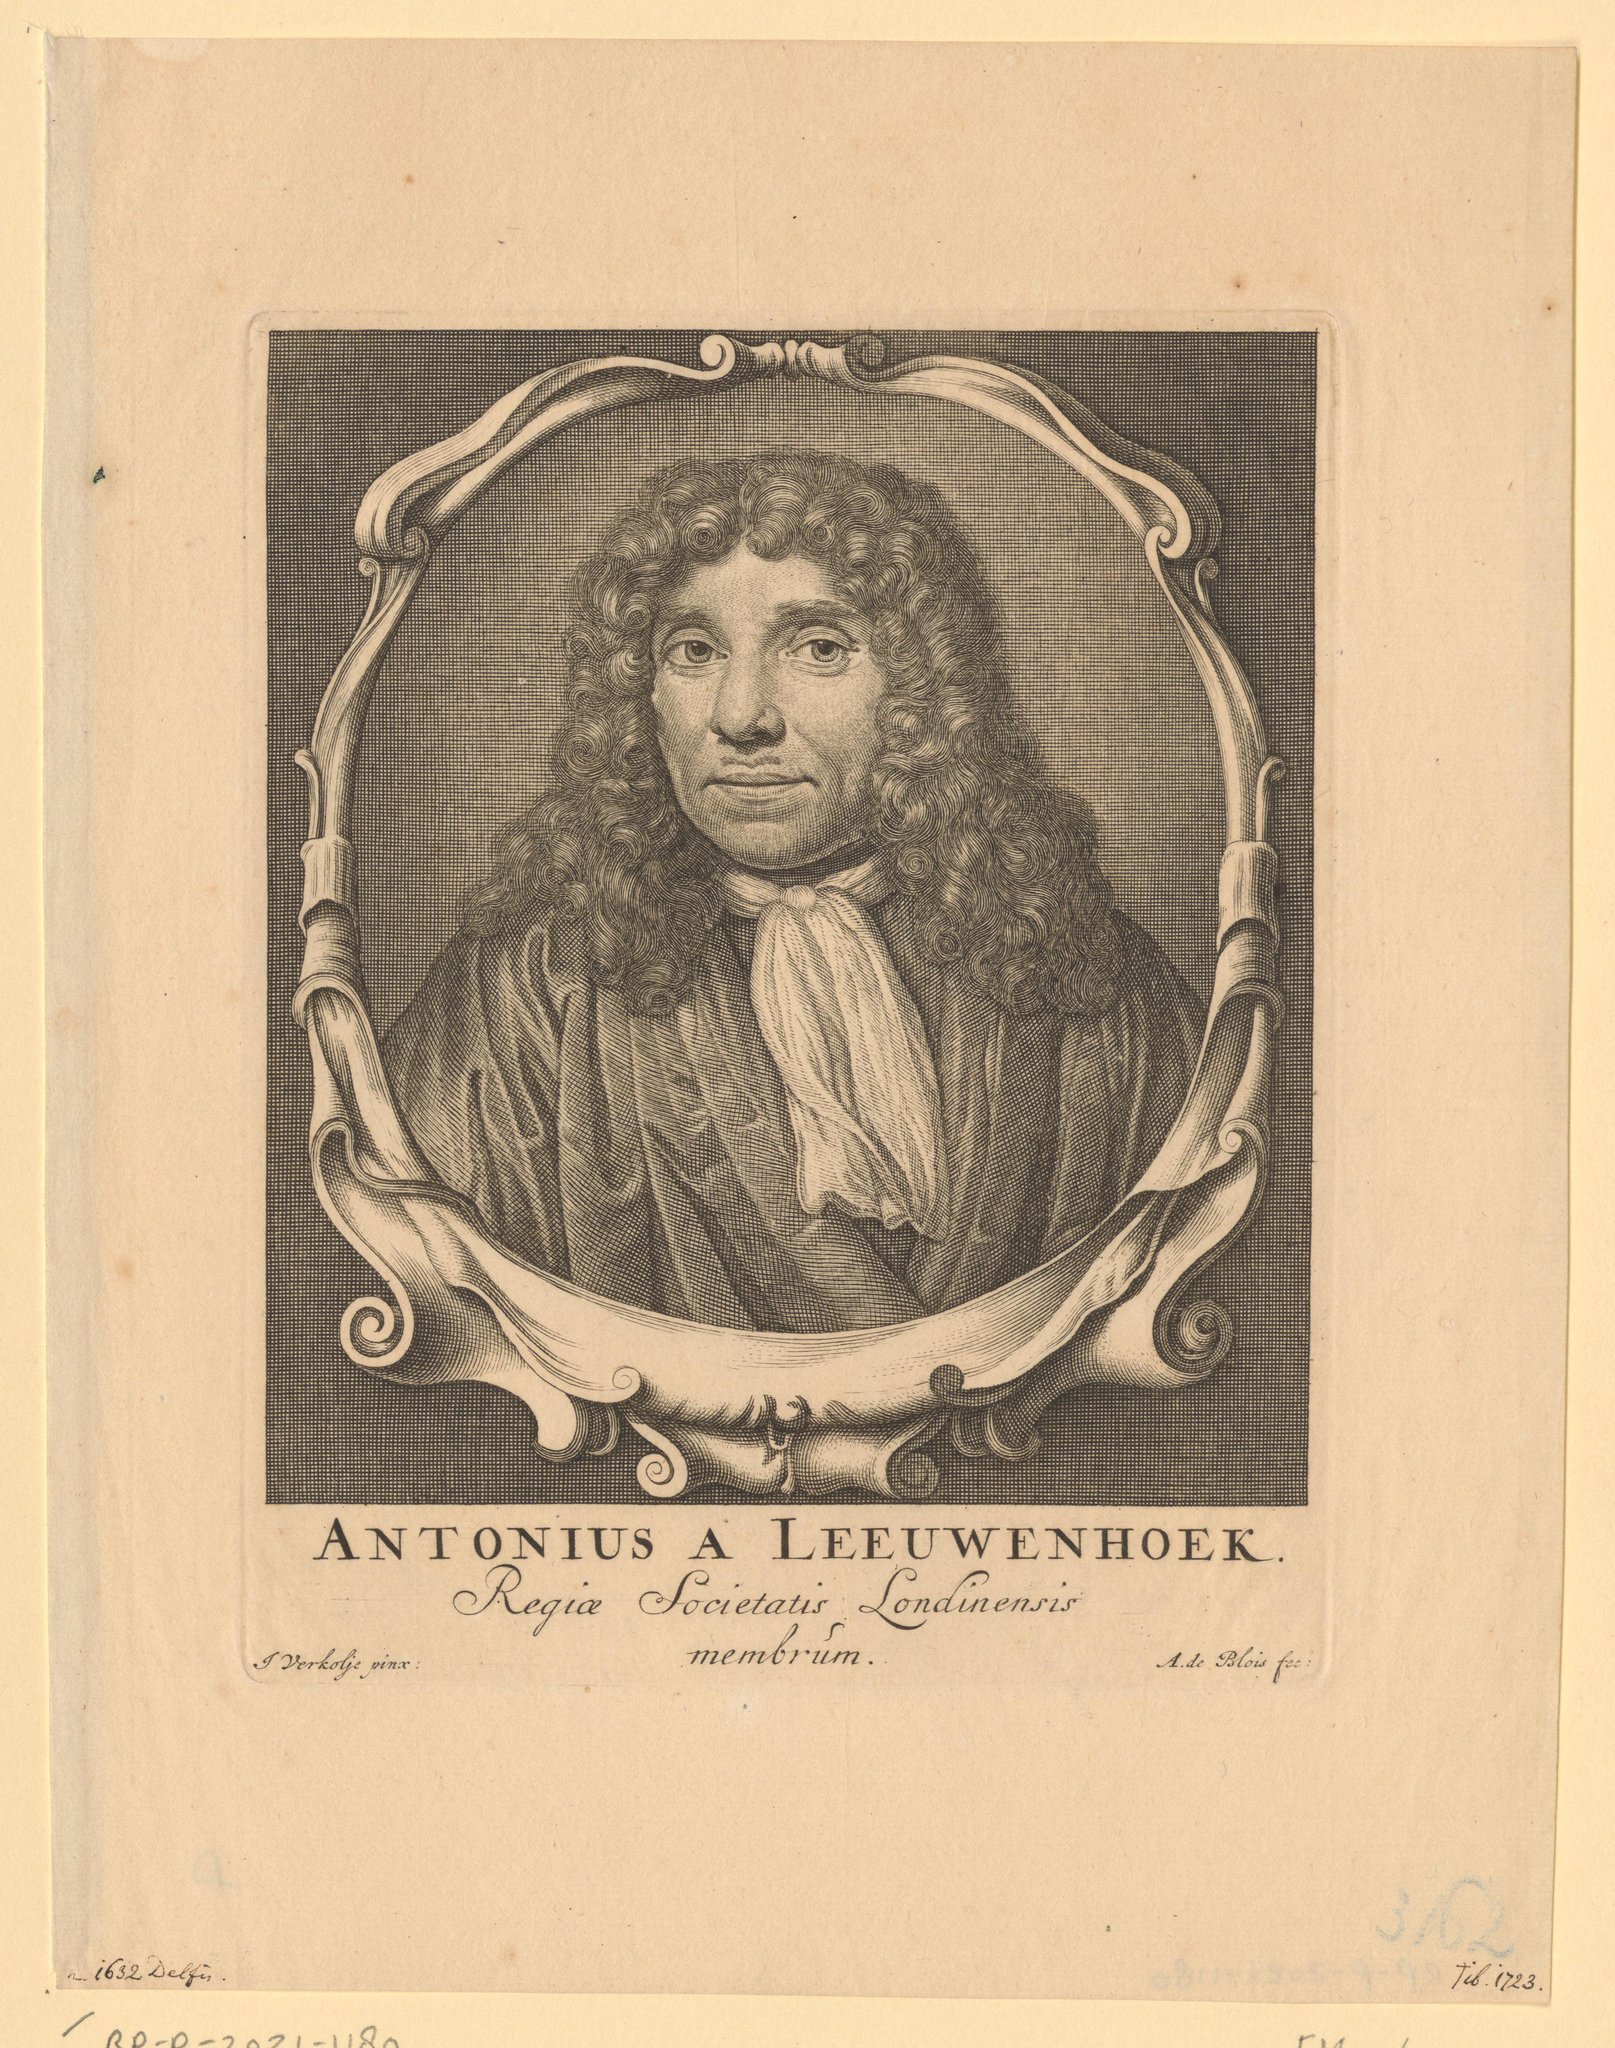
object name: print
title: Portret van Anthony van Leeuwenhoek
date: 1680-1717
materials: paper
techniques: engraving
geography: amsterdam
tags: anthony van leeuwenhoek, rocaille ornament, ornament ~ medallion, historical persons, science and technology (+ portrait of scholar, scientist)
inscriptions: inscription: ‘n. 1632 Delft +ib. 1723’